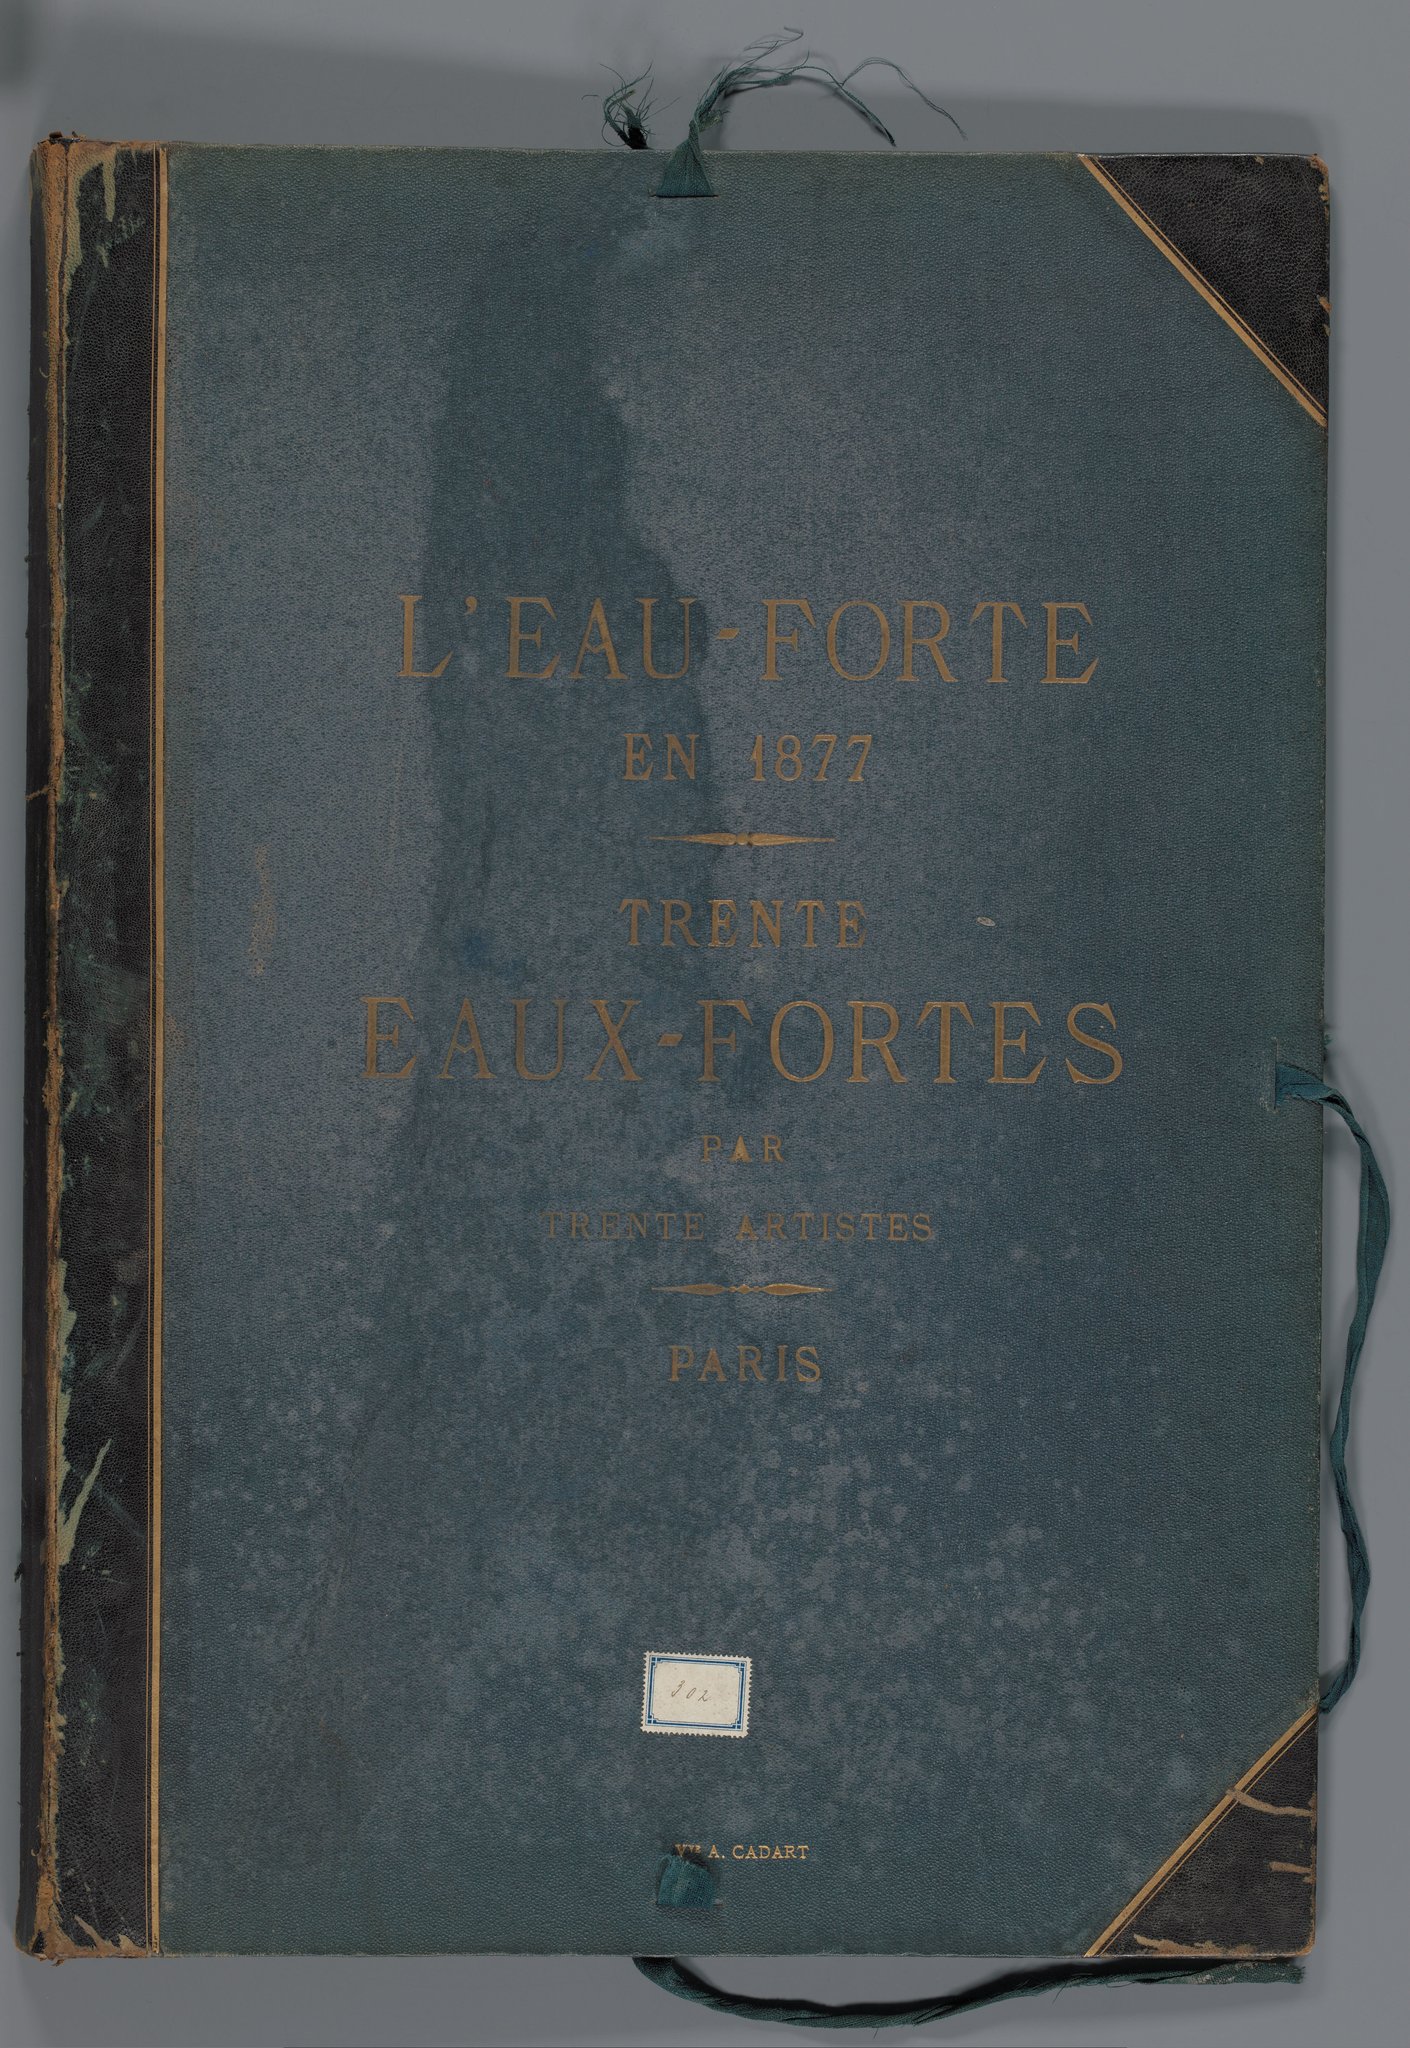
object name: wrapper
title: Franse etsen uit 1877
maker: weduwe alfred cadart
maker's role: printer, publisher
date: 1877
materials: cardboard, leather, linen, paper, ribbon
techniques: gold embossing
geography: paris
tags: city-view, and landscape with man-made constructions, adult woman, landscapes, beggar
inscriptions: collector's mark: Lugt 2760, number: ‘302’, collector's mark: ‘AFE v S’, collector's mark: Lugt 2228